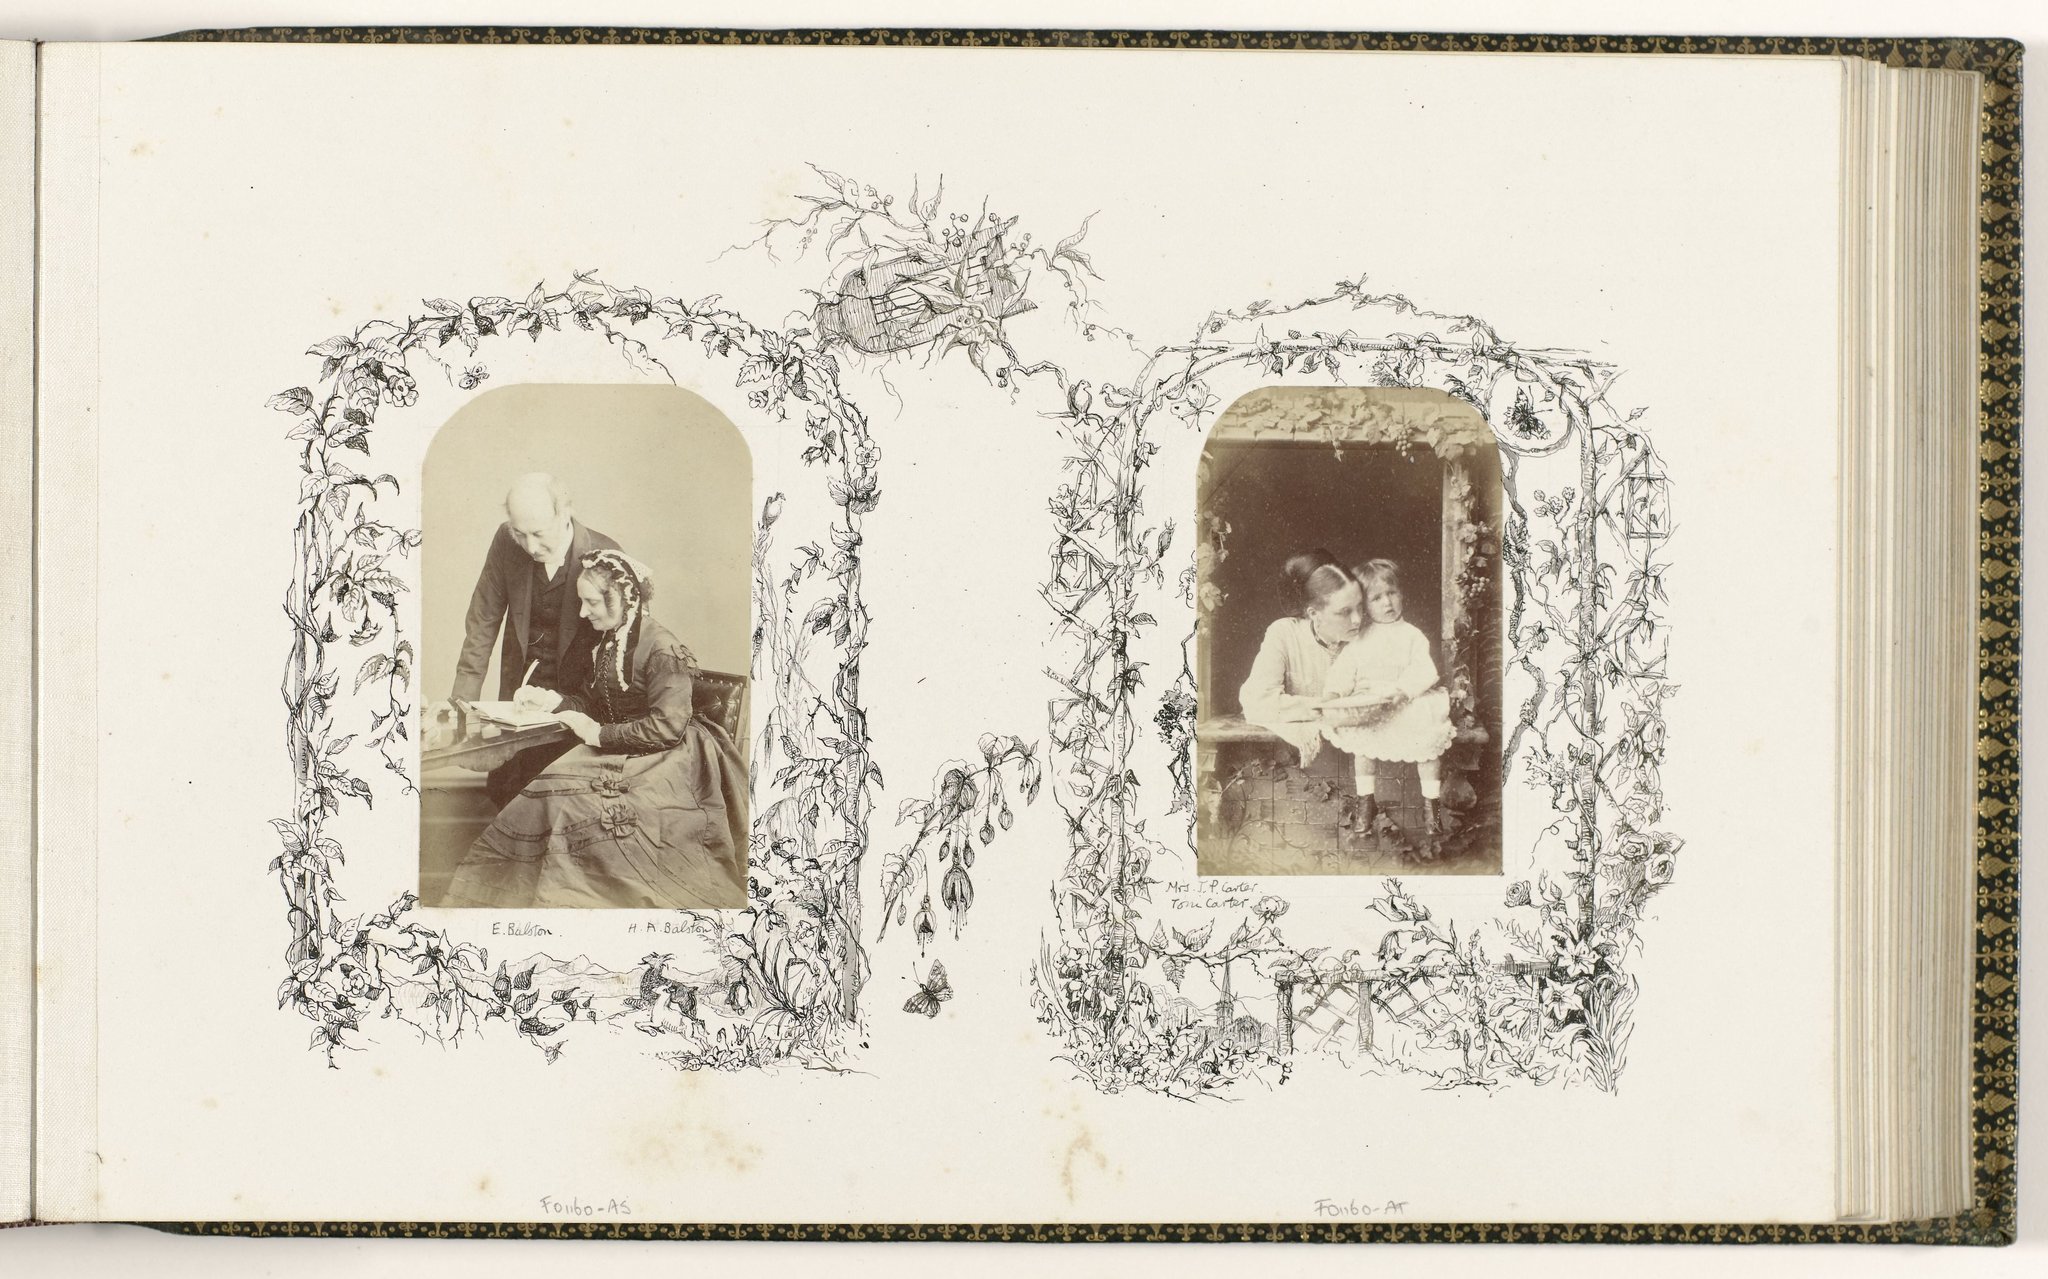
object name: photograph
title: Portret van een onbekend echtpaar, aangeduid als E. en H.A. Balston, aan tafel schrijvend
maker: Anonymous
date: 1865-1875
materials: paper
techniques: albumen print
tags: writing-table, writing-desk, historical persons, marriage, married couple, 'matrimonium'